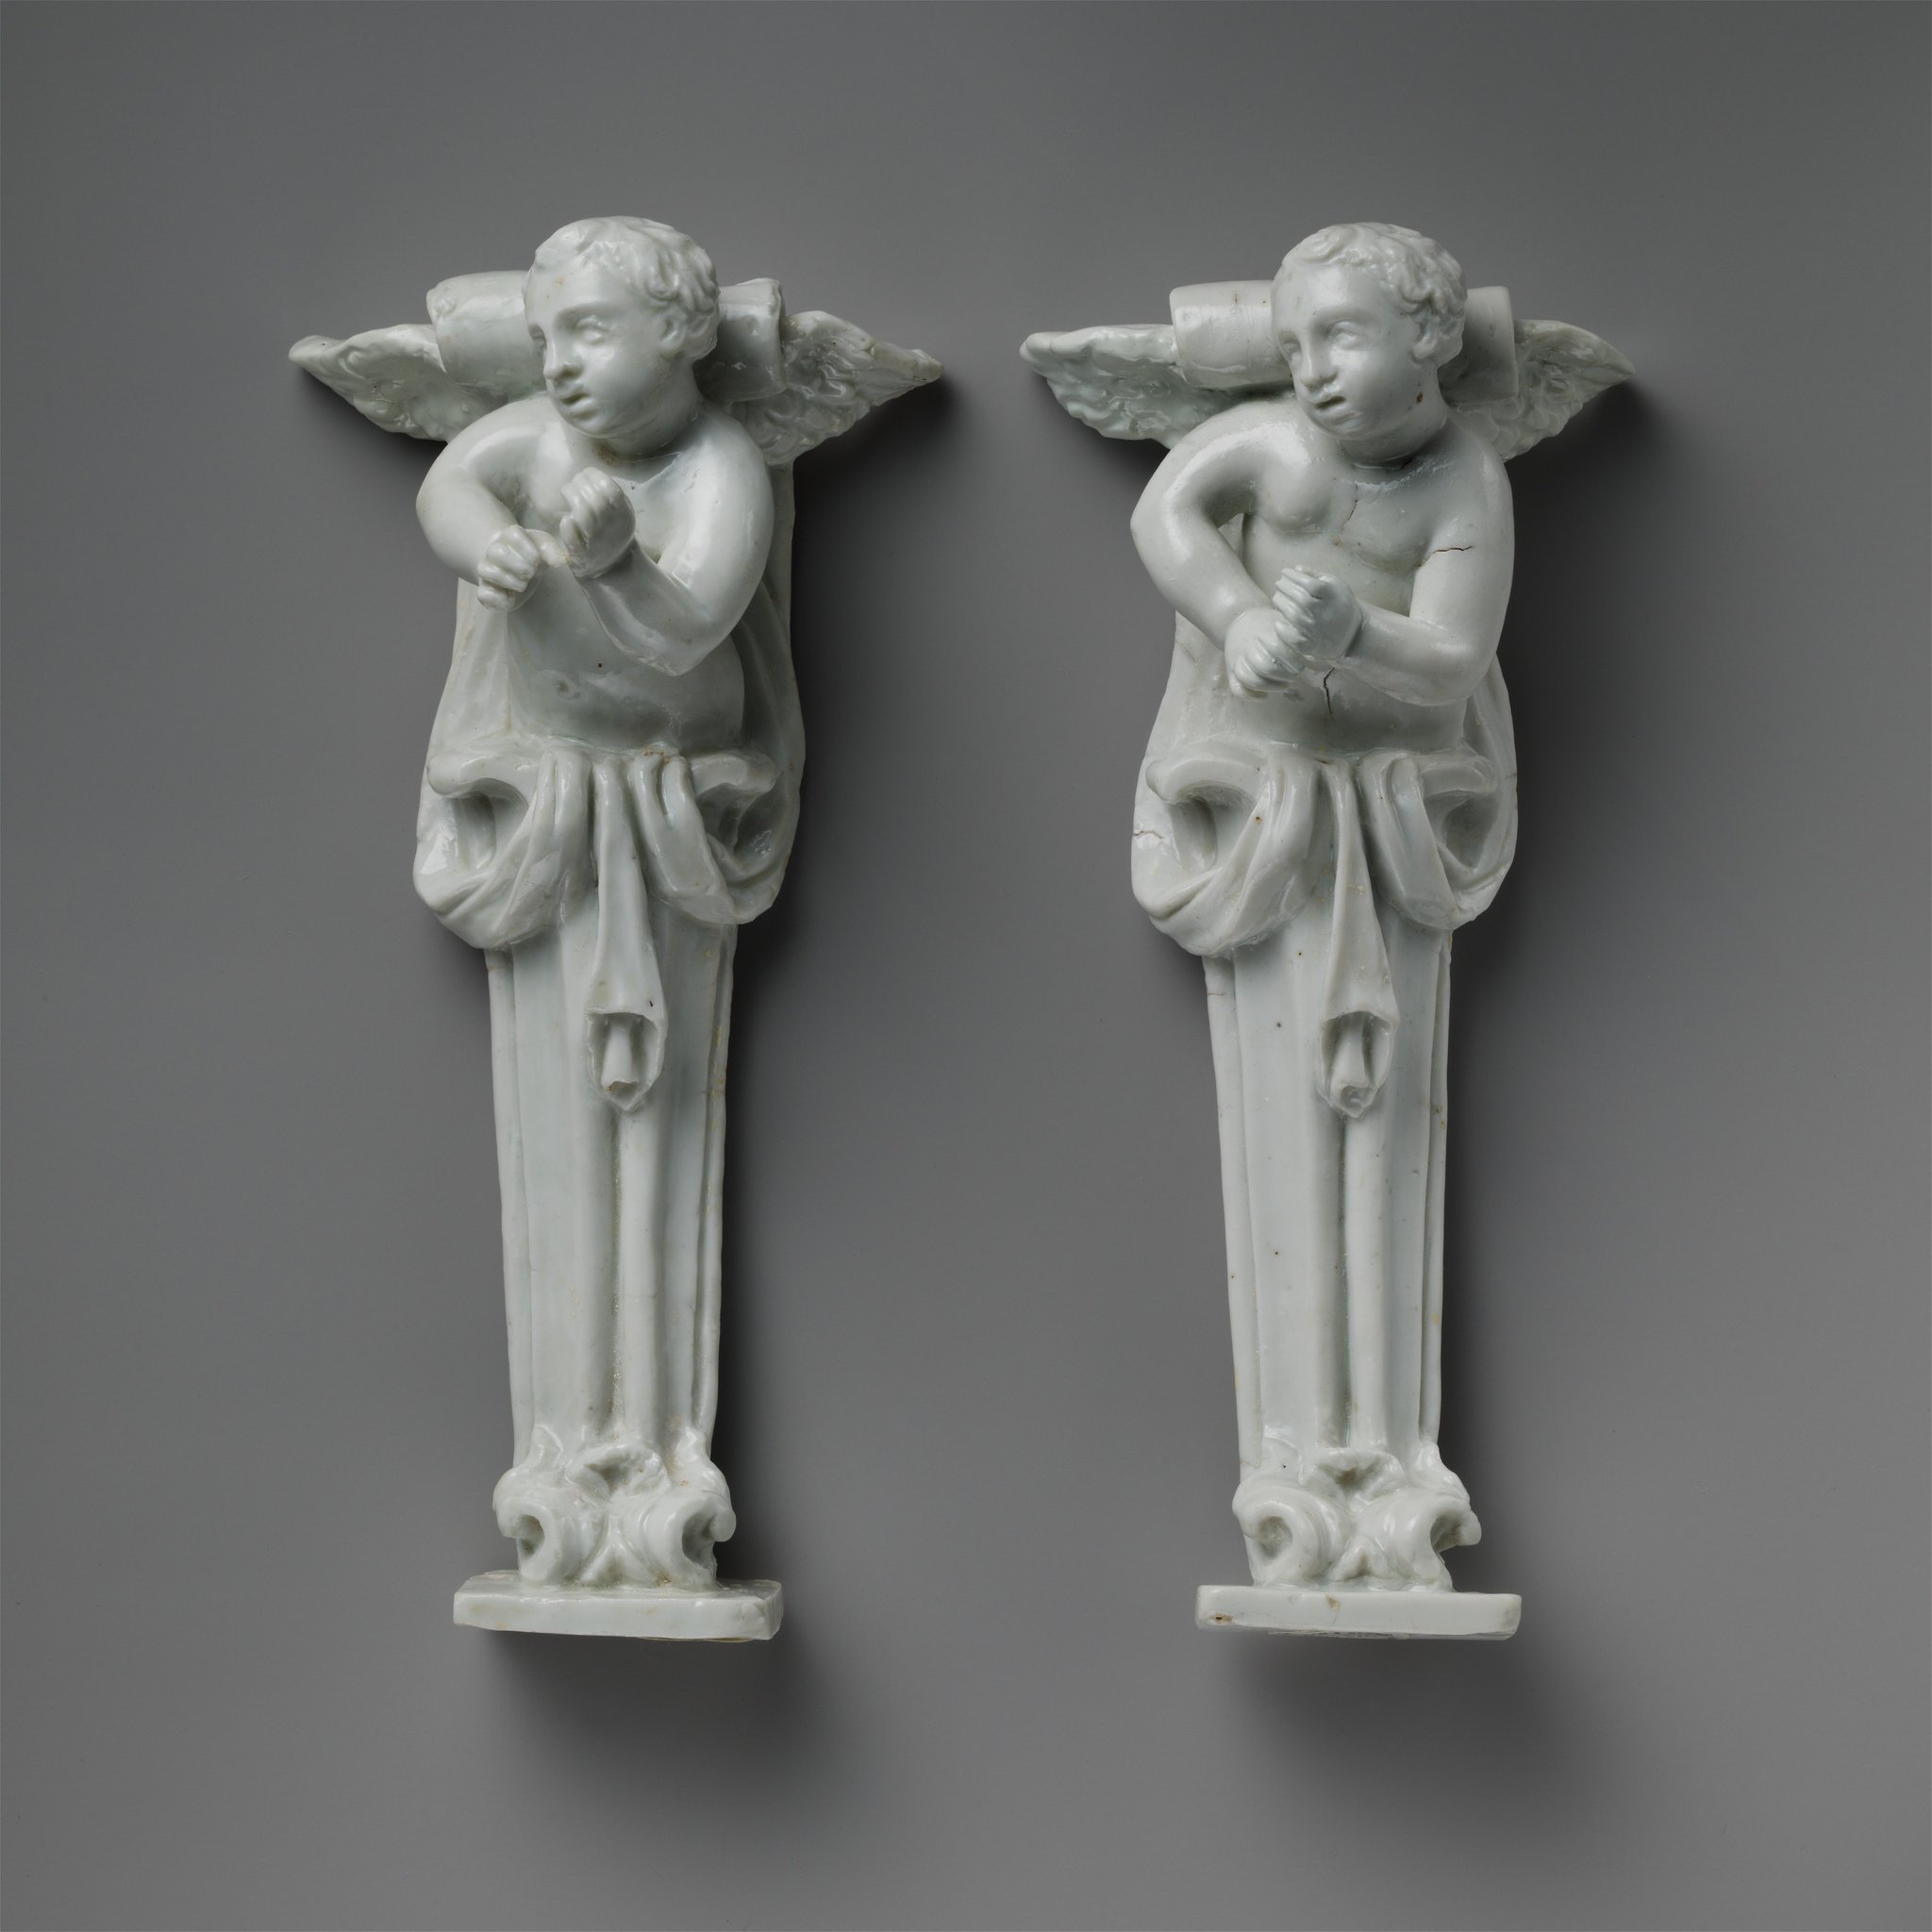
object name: term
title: Pair of terms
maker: doccia porcelain manufactory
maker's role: manufactory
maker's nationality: italian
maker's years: 1737-1896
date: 1745-1750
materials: hard paste porcelain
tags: putti